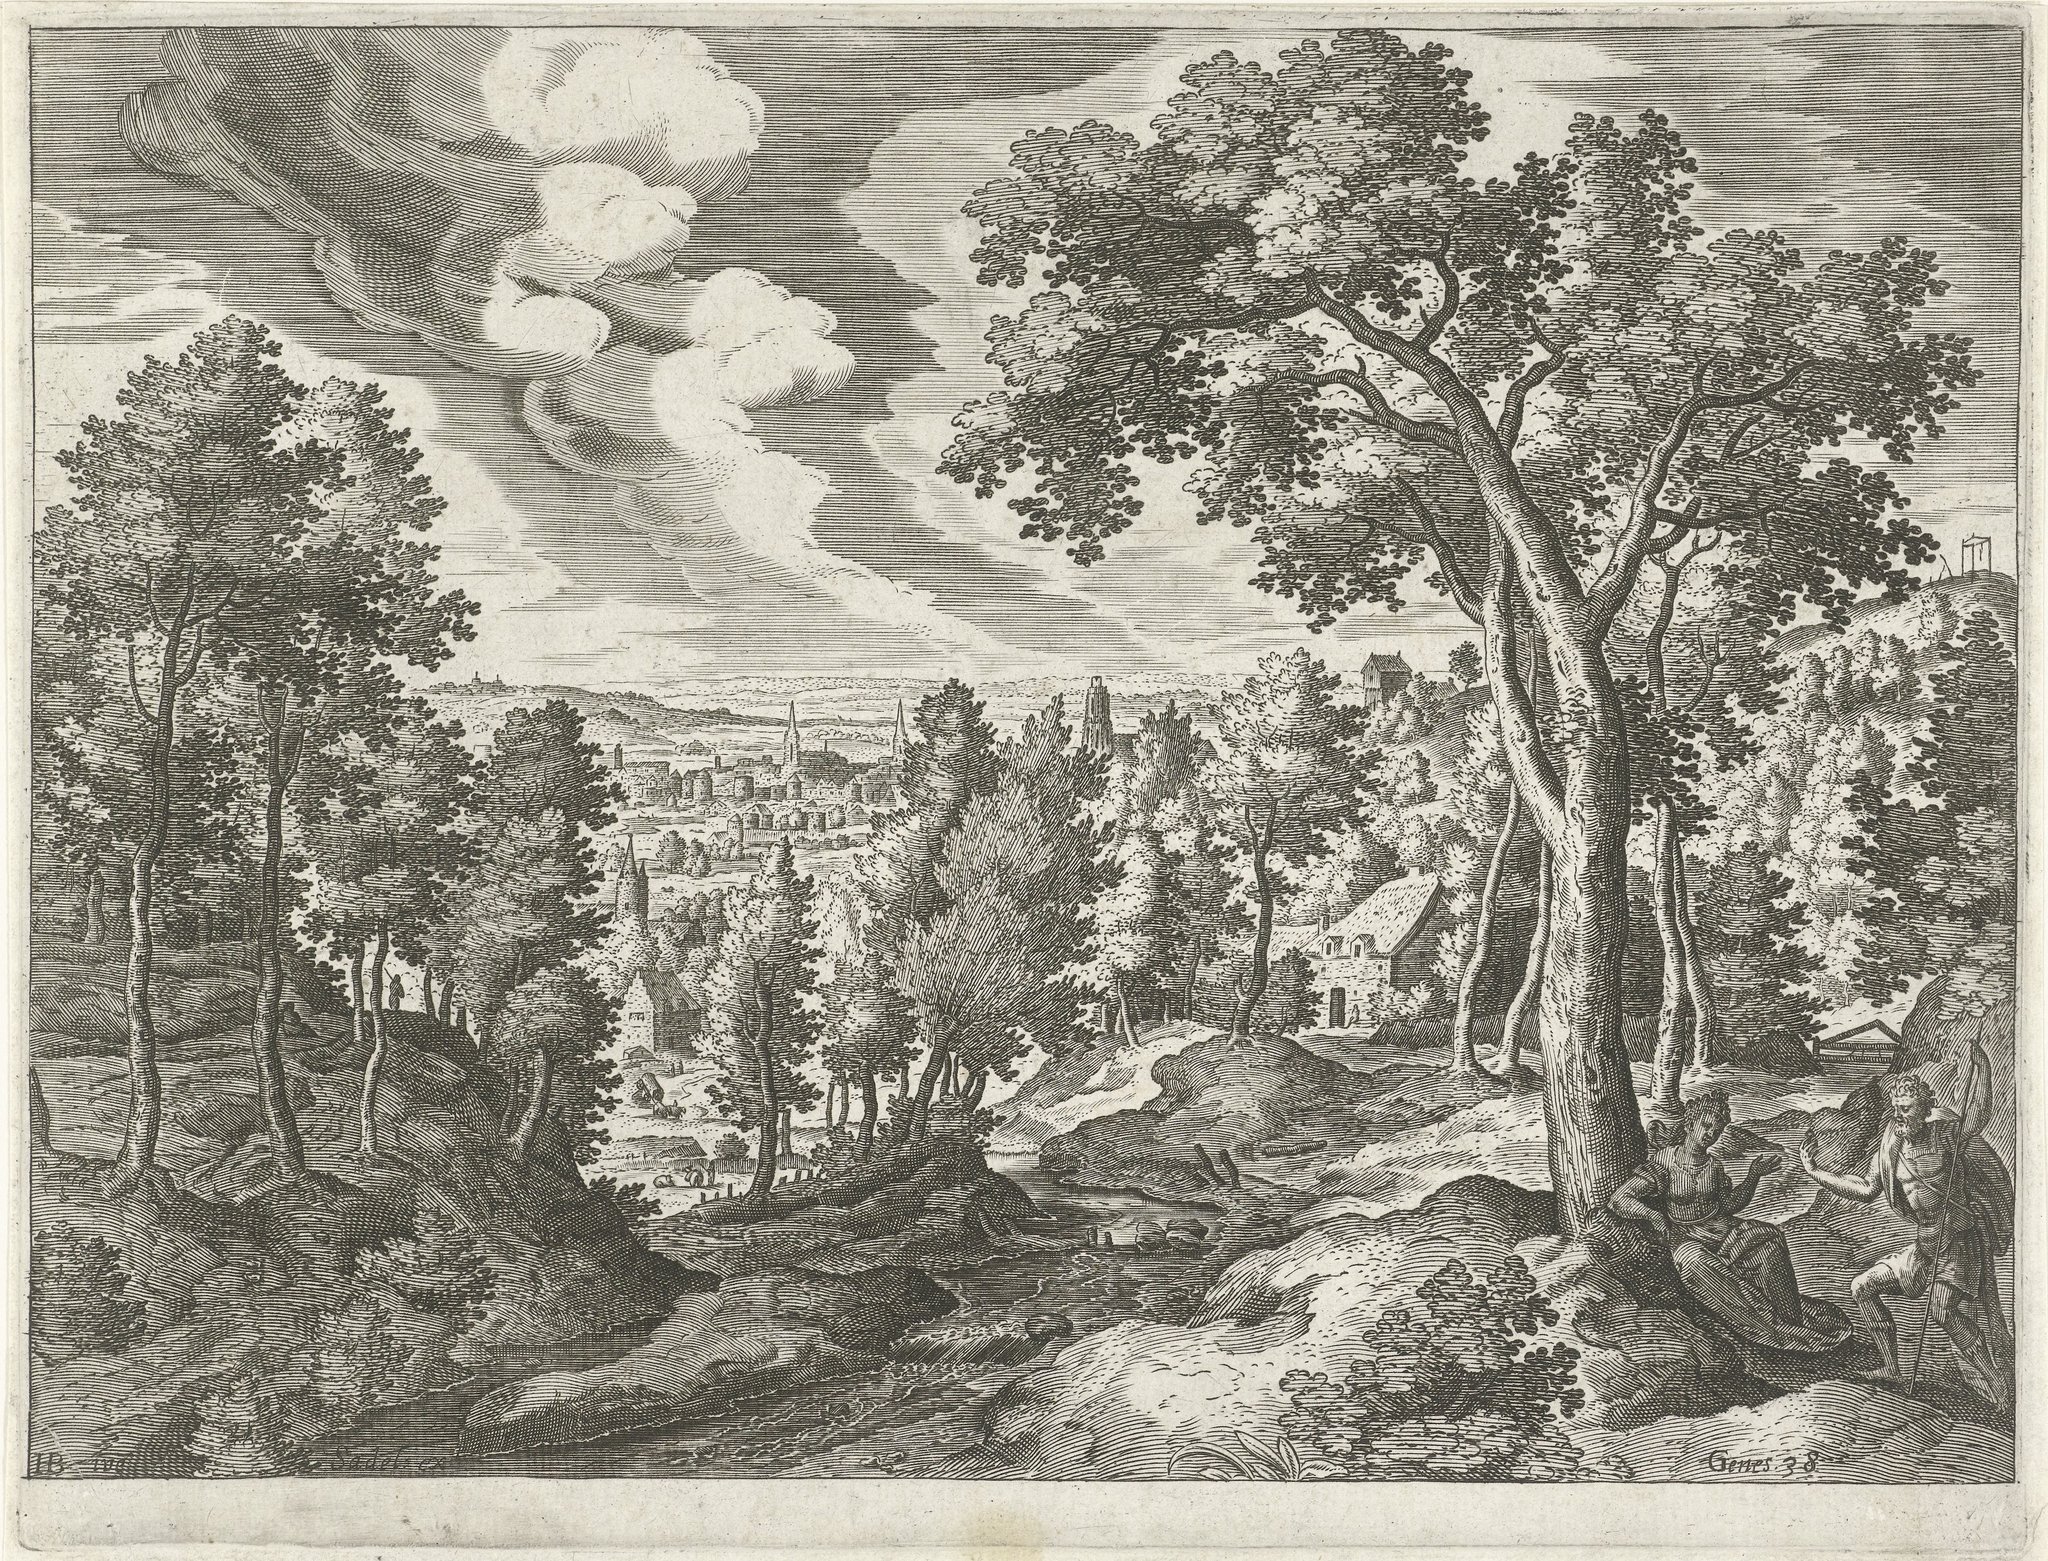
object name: print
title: Landschappen met scènes uit het Oude en Nieuwe Testament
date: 1580-1600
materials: paper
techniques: engraving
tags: story of judah and tamar (genesis 38), deciduous forest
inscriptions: collector's mark: Lugt 240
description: Bebost landschap. Rechts op een weg geeft Juda een ring aan Tamar. Door zich als hoer te verkleden, verleidt Tamar haar schoonvader Juda. Tamar raakt zwanger en kan door middel van de ring die Juda haar heeft gegeven als betaling bewijzen dat hij de vader van haar kind is. De prent is deel van een achtdelige serie van landschappen met scènes uit het Oude en Nieuwe Testament.